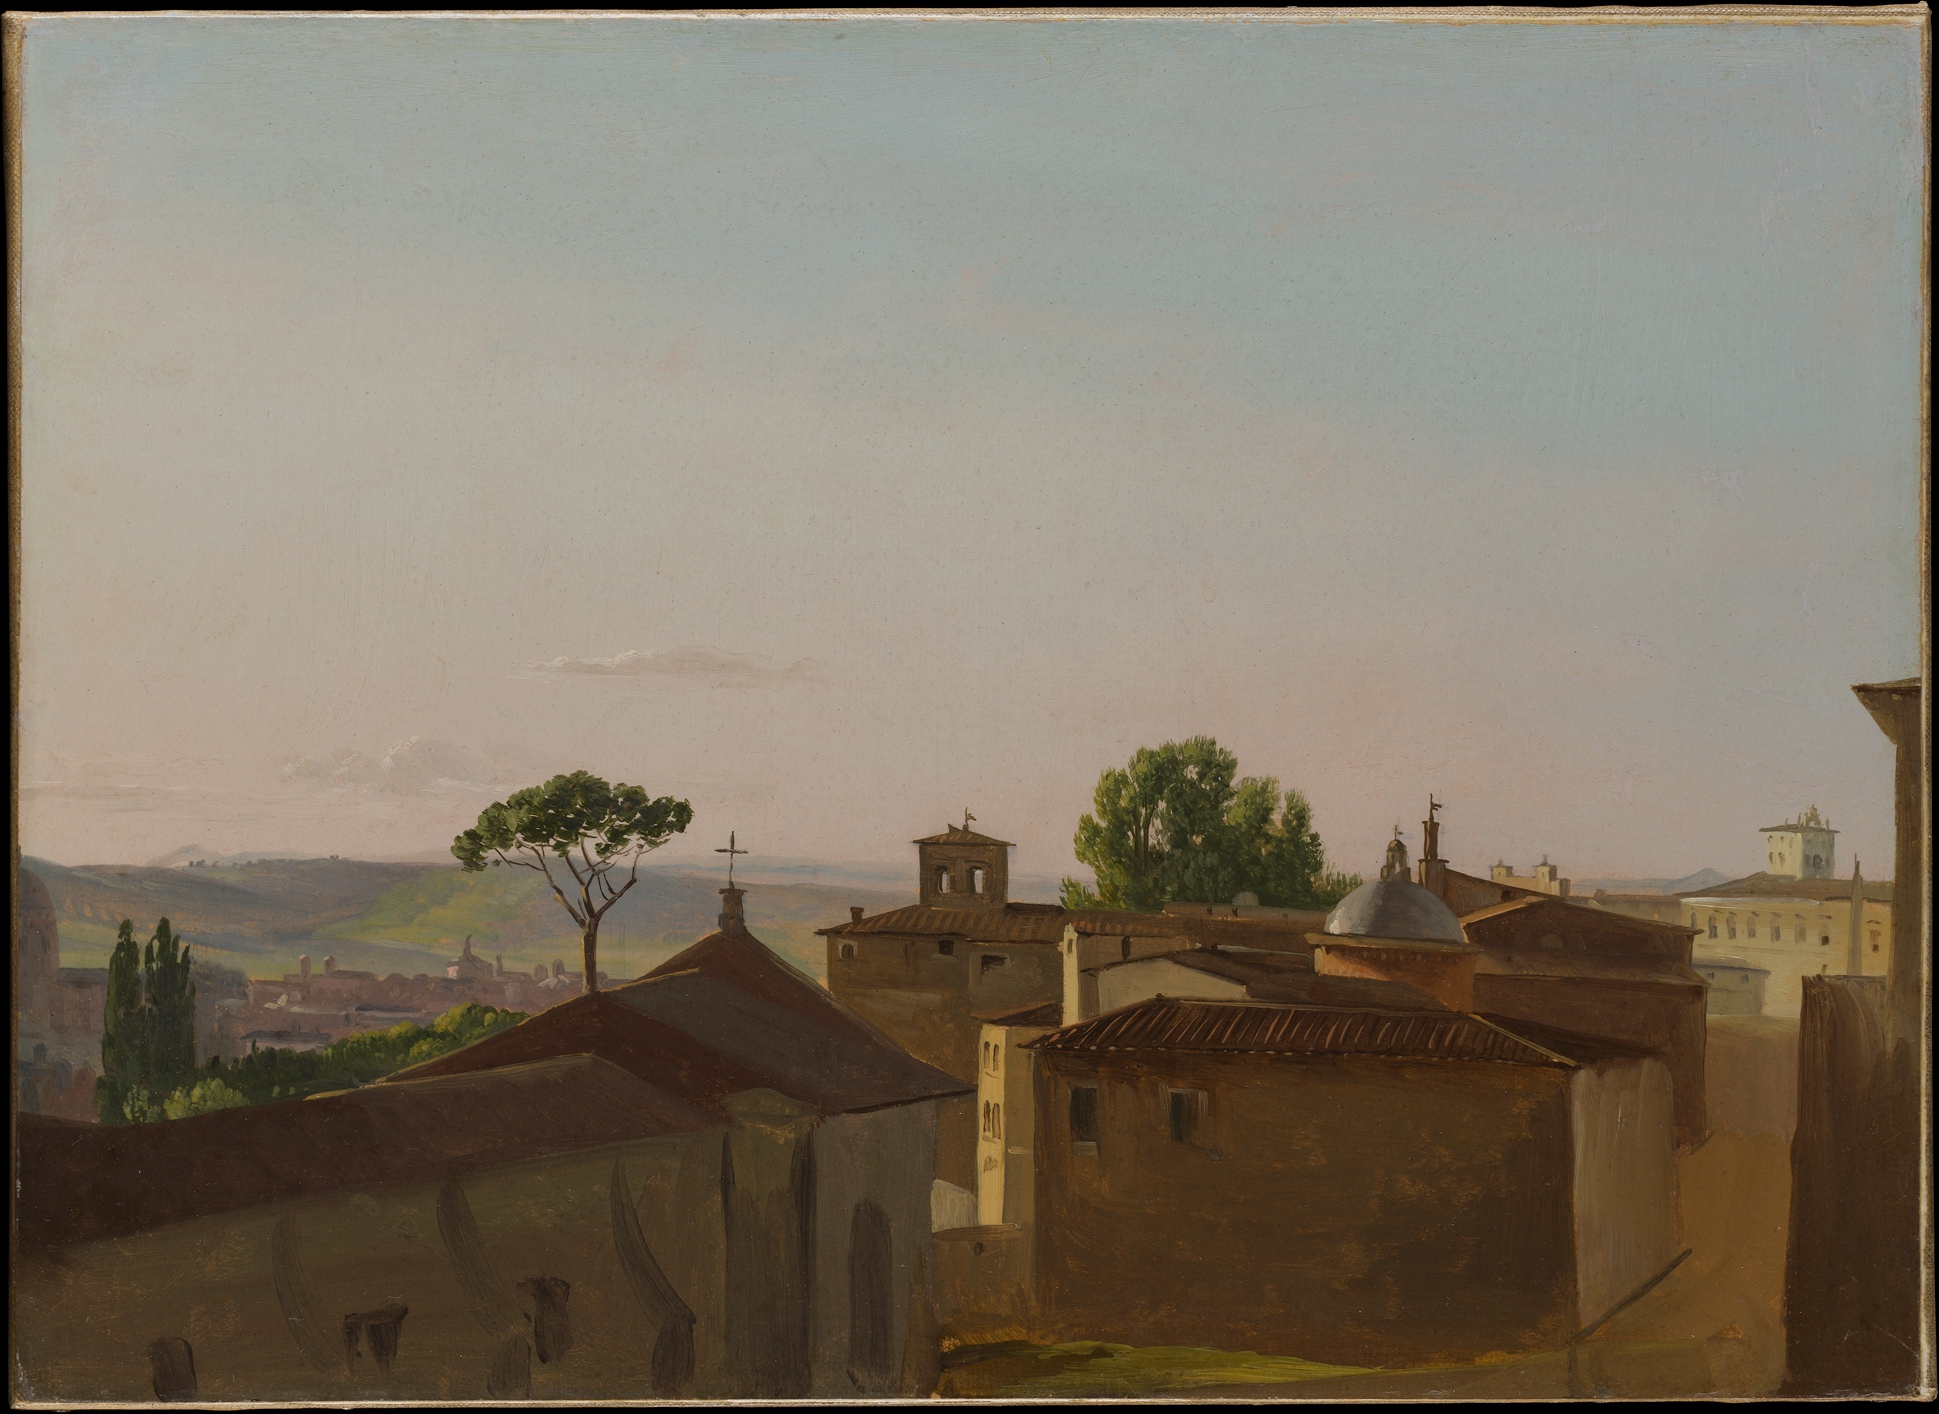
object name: painting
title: View on the Quirinal Hill, Rome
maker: simon denis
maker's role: artist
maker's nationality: flemish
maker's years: 1755-1813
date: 1800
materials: canvas, oil, paper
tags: cities,rome